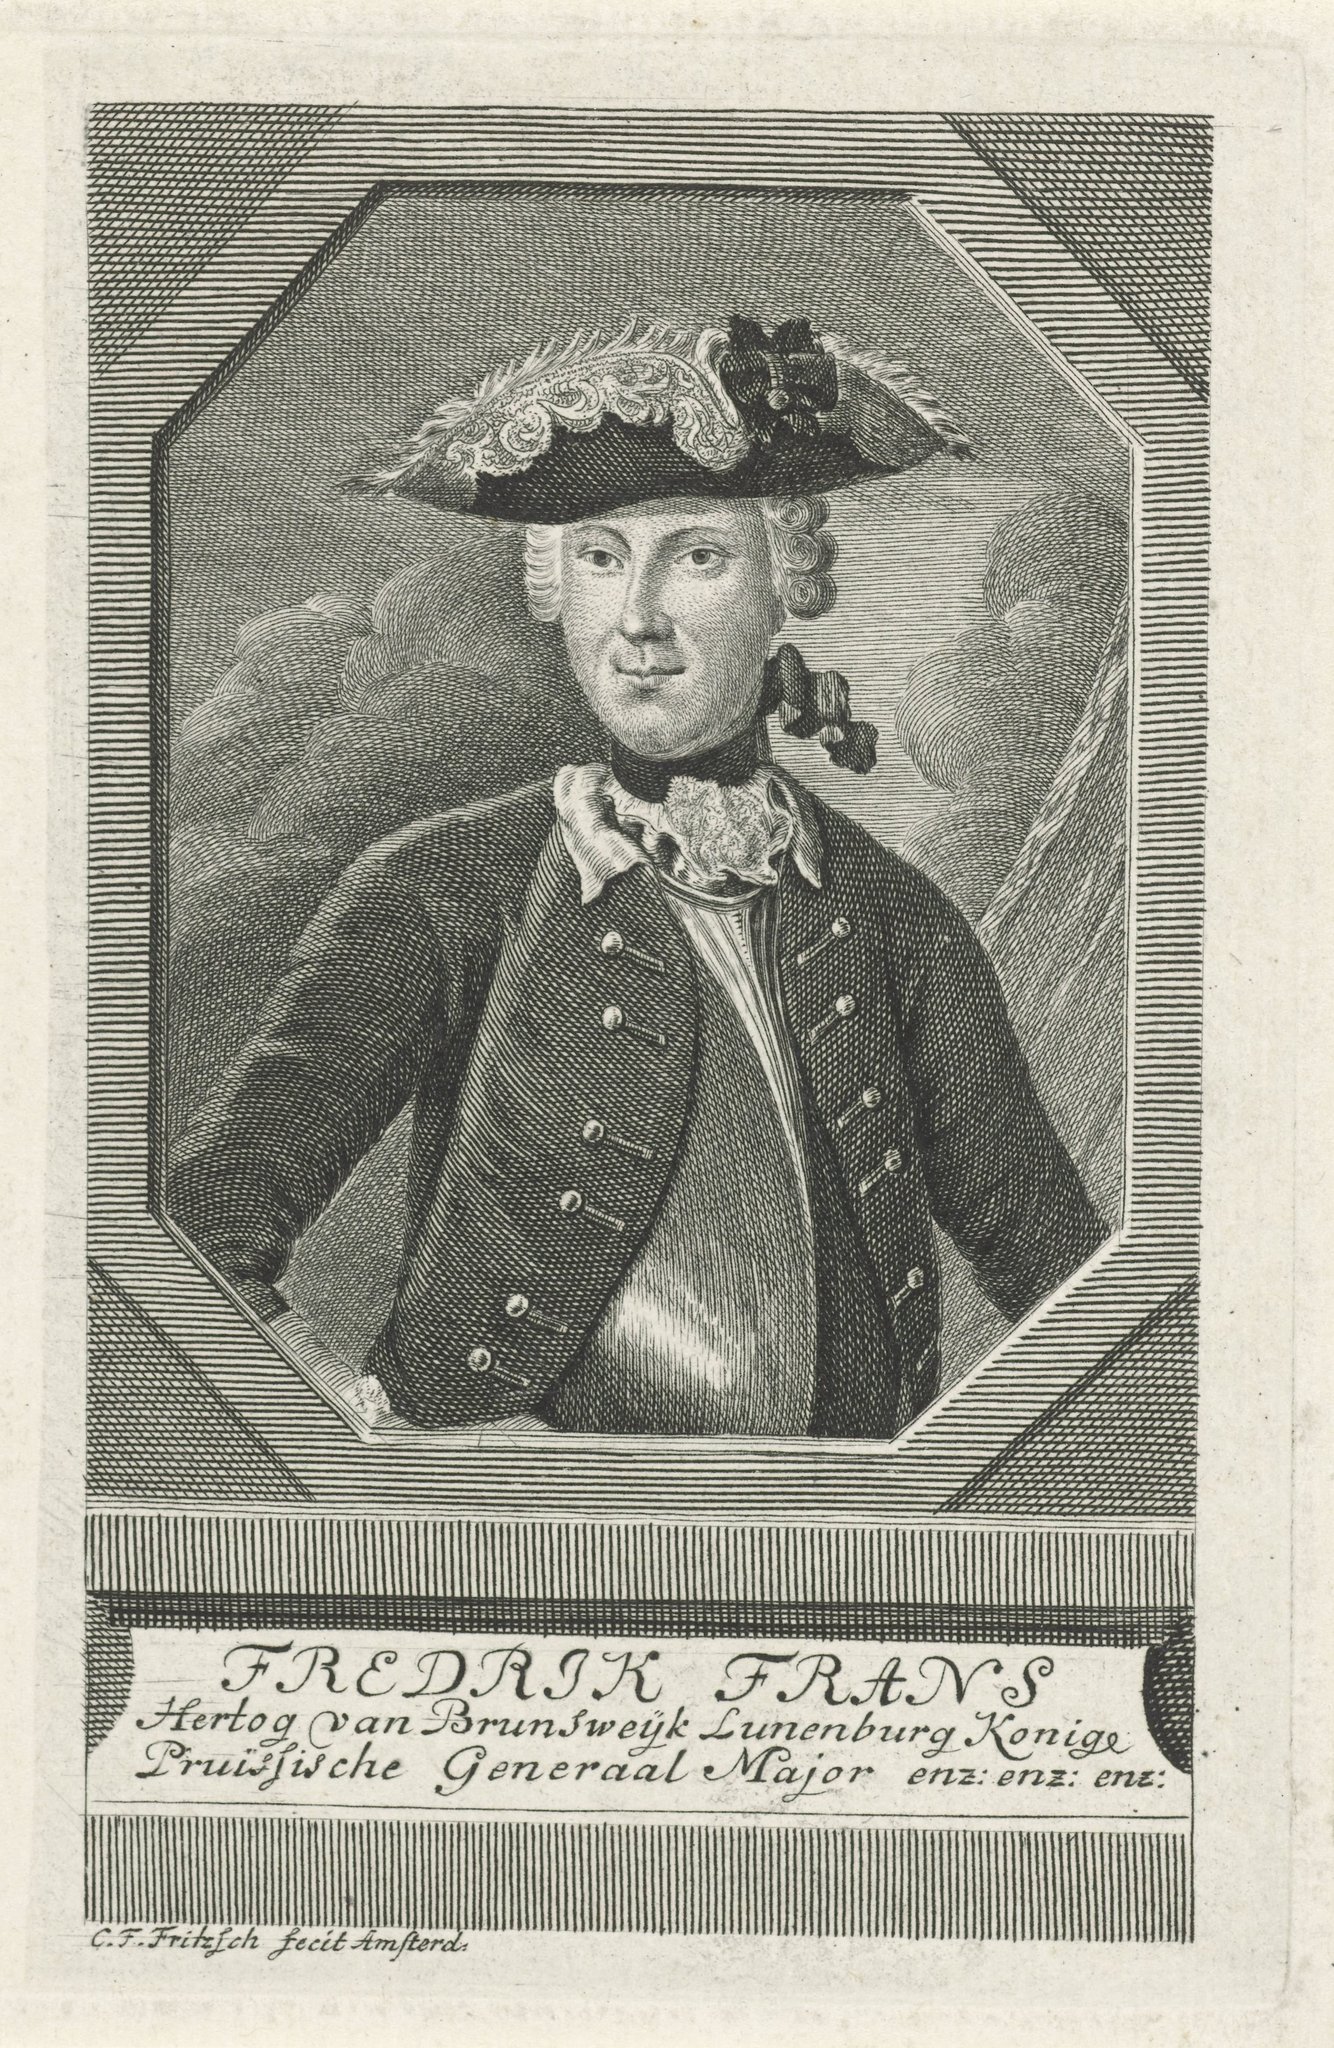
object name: print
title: Portret van Frederik Frans, hertog van Brunswijk-Luneburg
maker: christian friedrich fritzsch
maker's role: print maker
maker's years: 1719-1774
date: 1729-1774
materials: paper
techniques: engraving, etching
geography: amsterdam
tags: frederik frans hertog van brunswijk-luneburg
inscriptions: collector's mark: Lugt 2228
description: Portretbuste in achthoek van Frederik Frans, hertog van Brunswijk-Luneburg. Het hoofd is licht naar links gedraaid en getooid met een steek. Onder het ovaal staan zijn naam en titels.